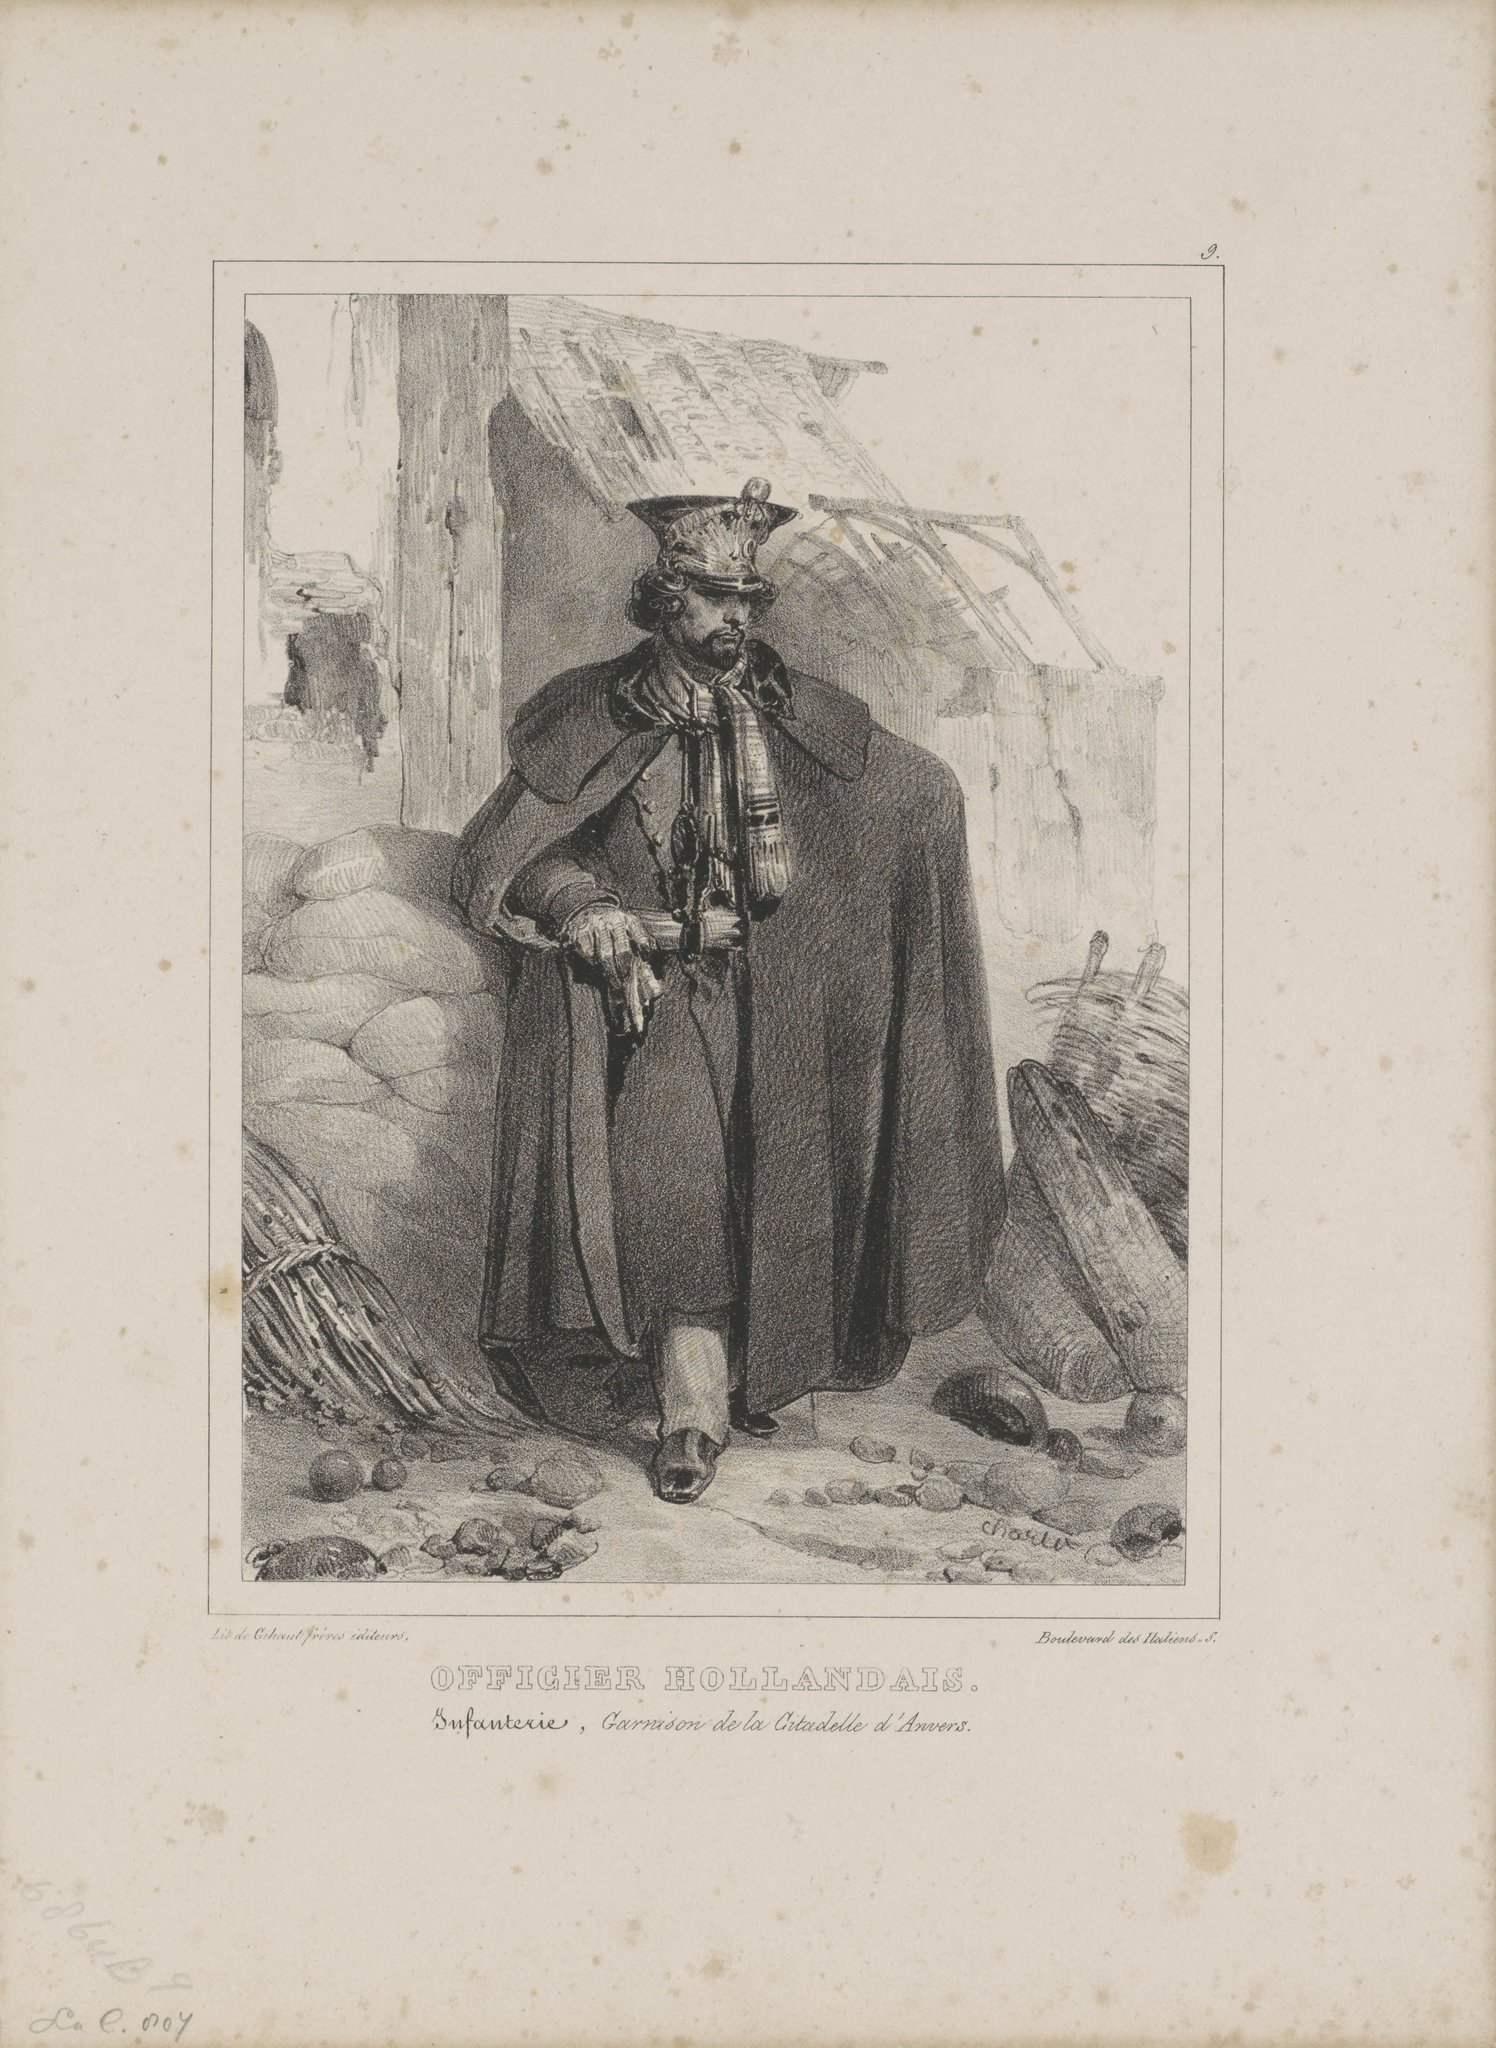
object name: print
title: Nederlandse officier, 1832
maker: nicolas toussaint charlet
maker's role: draughtsman, painter, print maker, printer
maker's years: 1792-1845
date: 1832-1833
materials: paper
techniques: lithograph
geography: paris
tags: officer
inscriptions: collector's mark: Lugt 2228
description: Nederlandse officier van de infanterie, staande geleund op een muur van zandzakken; onderdeel van het garnizoen in de Citadel van Antwerpen, november-december 1832. Onderdeel van een serie van twintig bladen uit 1833 met voorstellingen van de militaire interventie van het Franse Noordelijke Leger in België in 1832.